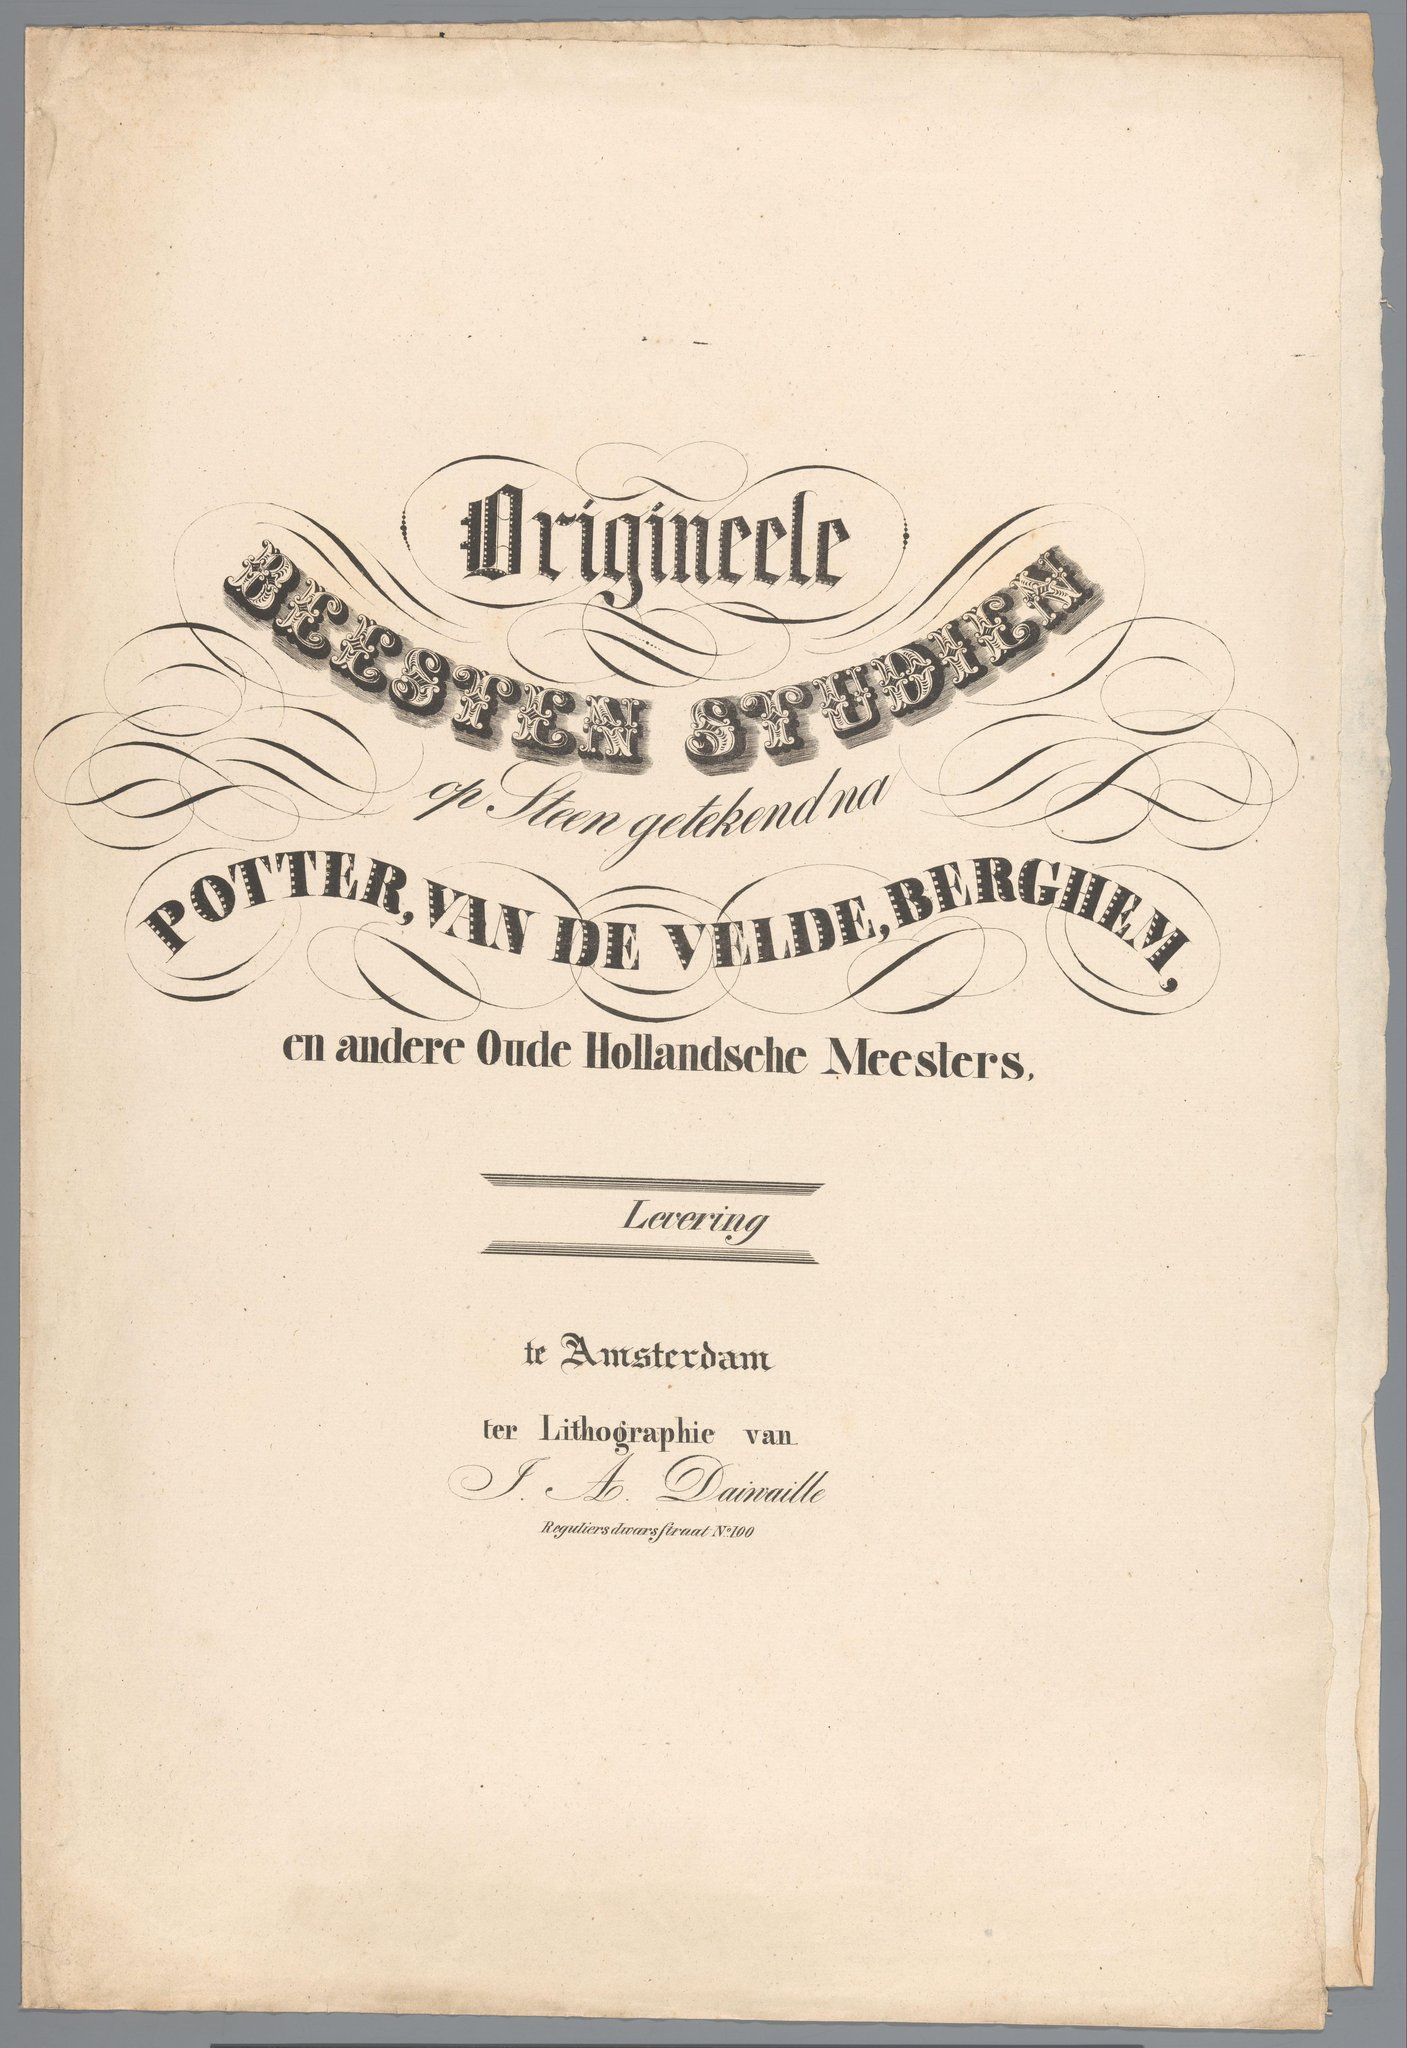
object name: print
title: Origineele Beesten Studien op Steen getekend na Potter, Van de Velde, Berghem, en andere Oude Hollandsche Meesters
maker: jean augustin daiwaille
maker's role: draughtsman, print maker, printer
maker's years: 1786-1850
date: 1820-1833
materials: paper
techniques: lithograph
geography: amsterdam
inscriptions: collector's mark: Lugt 2228